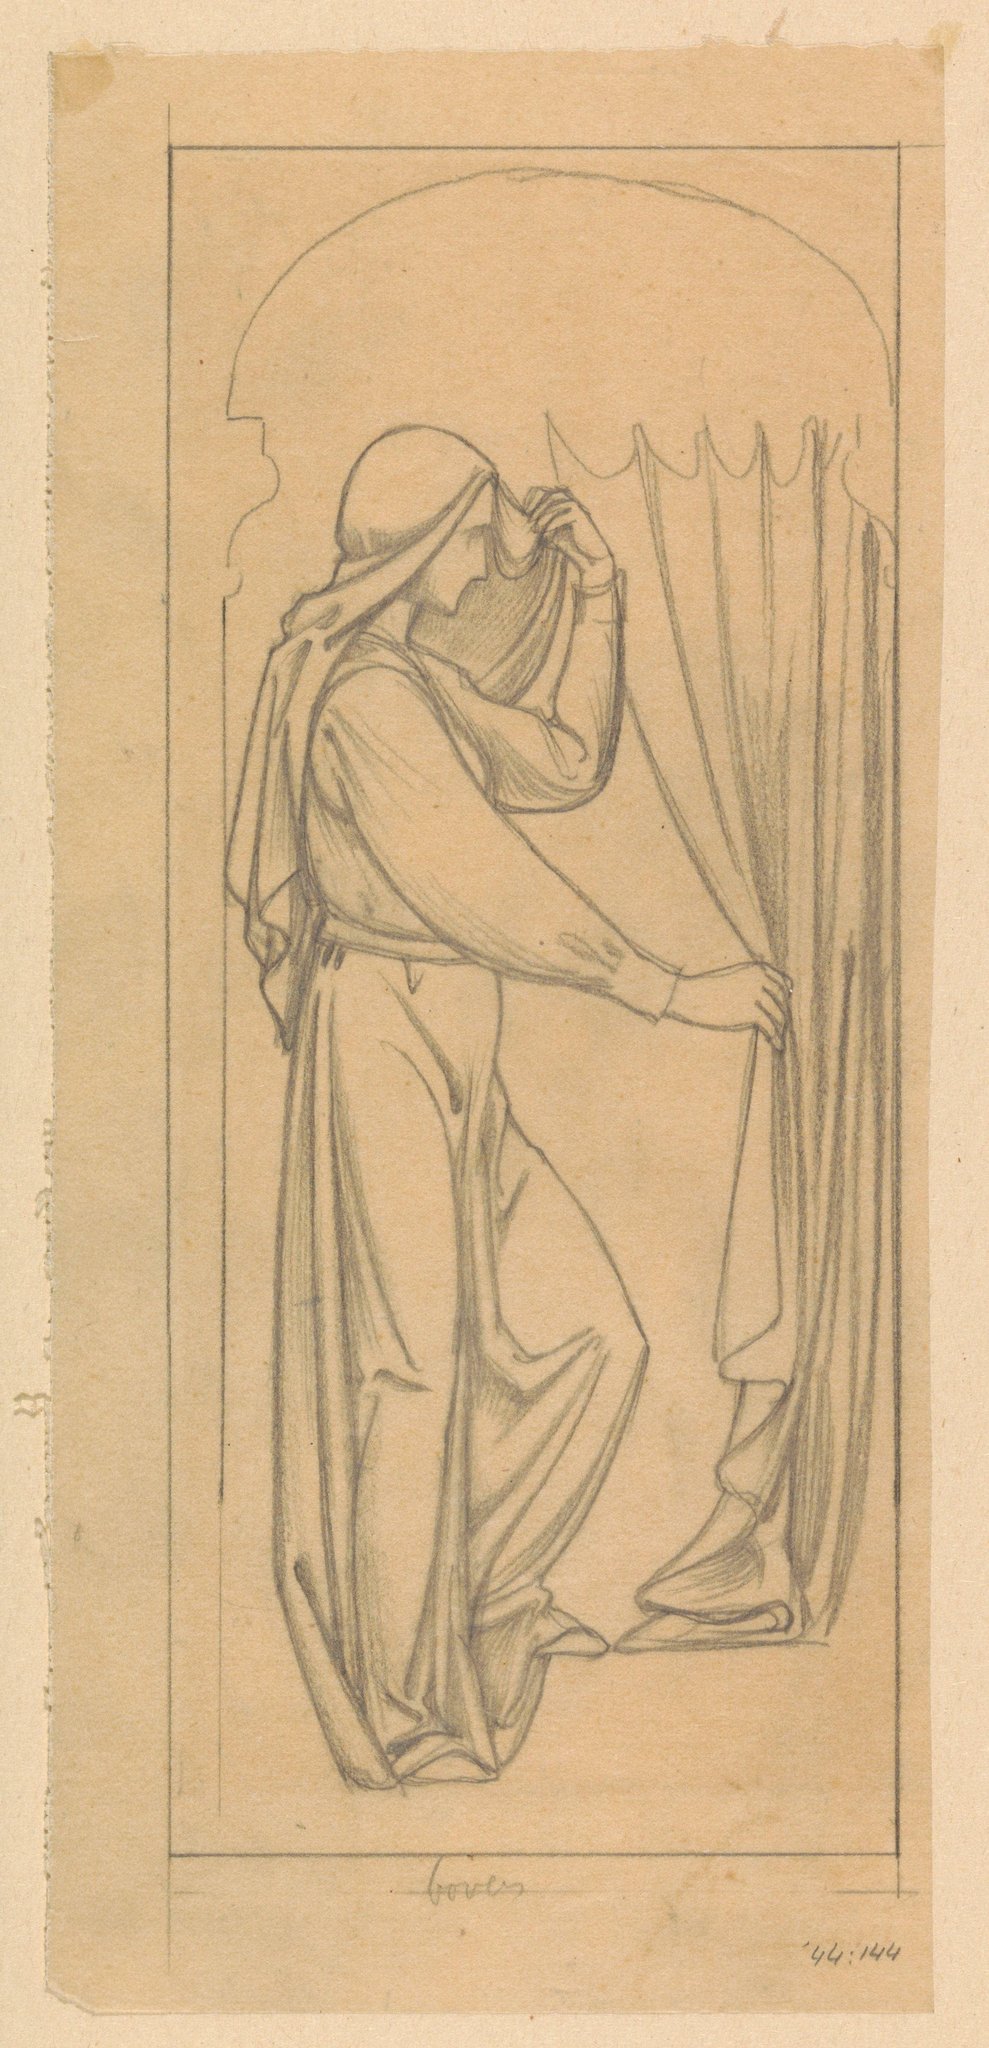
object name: design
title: Ontwerp voor wandschildering in de Beurs van Berlage: staande vrouw die een gordijn opzij duwt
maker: antoon derkinderen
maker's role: draughtsman, painter, print maker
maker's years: 1859-1925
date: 1869-1925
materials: pencil, paper